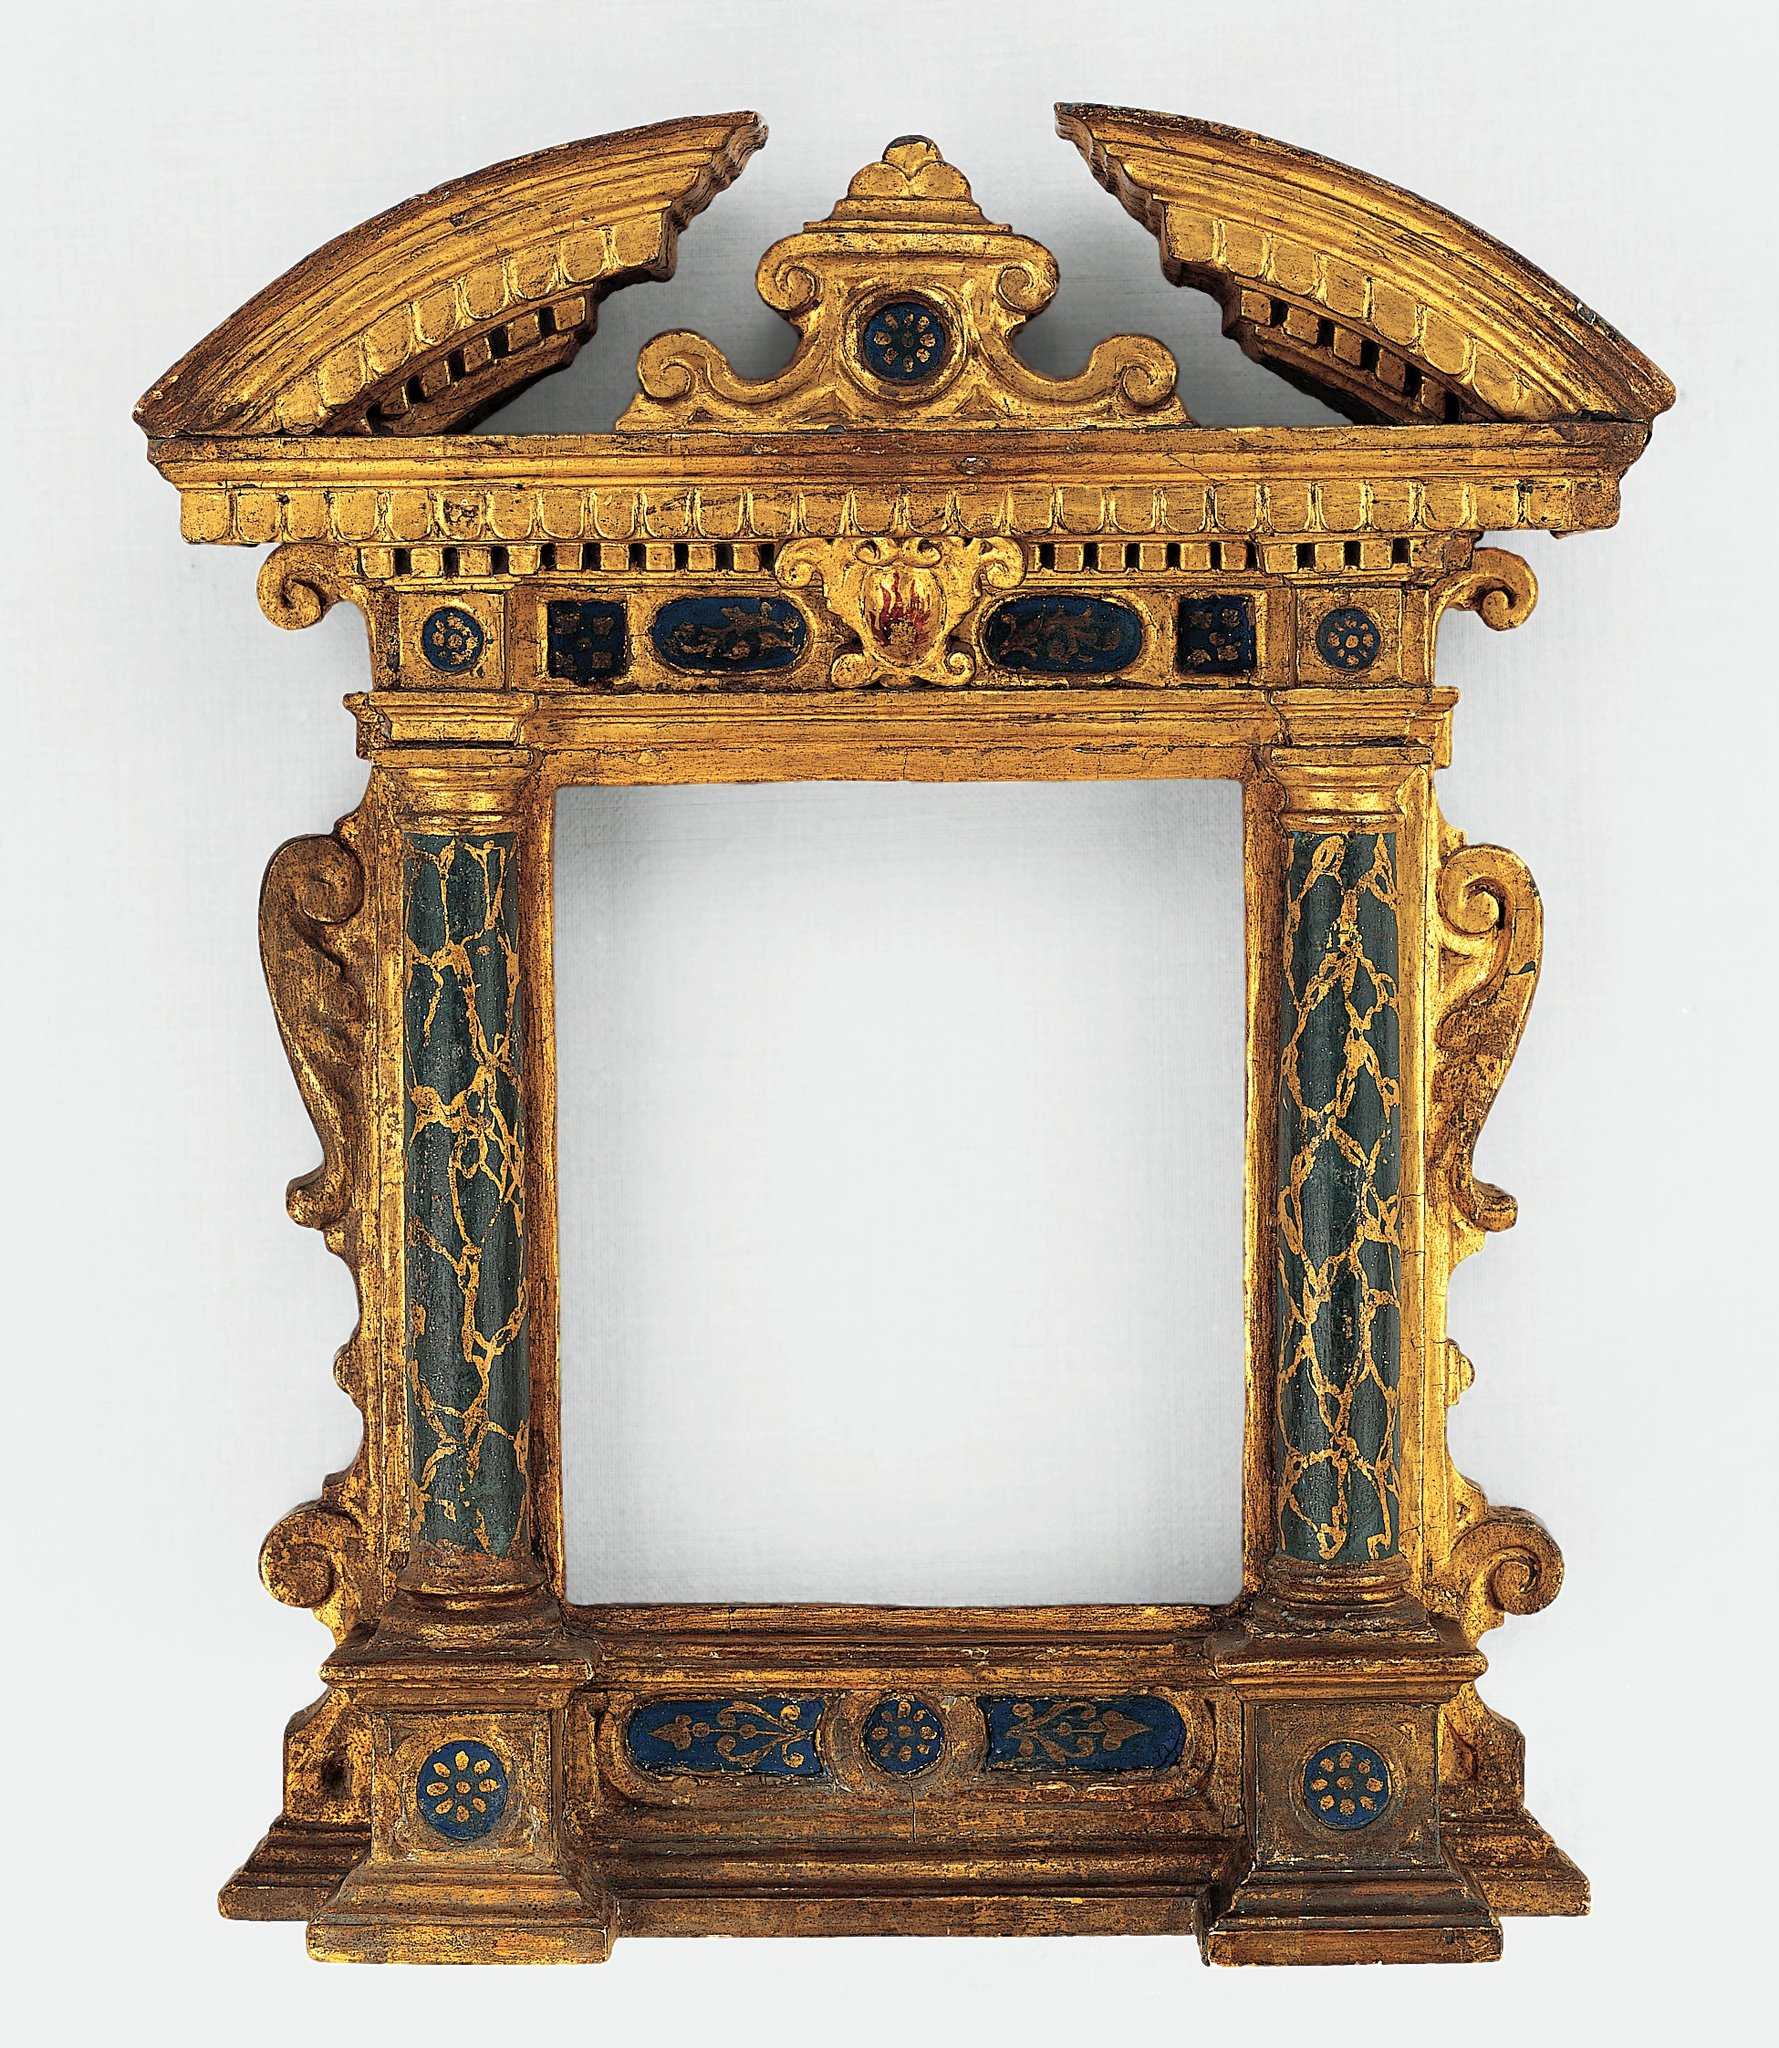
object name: frame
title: Tabernacle frame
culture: italian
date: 1601-1633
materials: gilt, wood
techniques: carving, painting